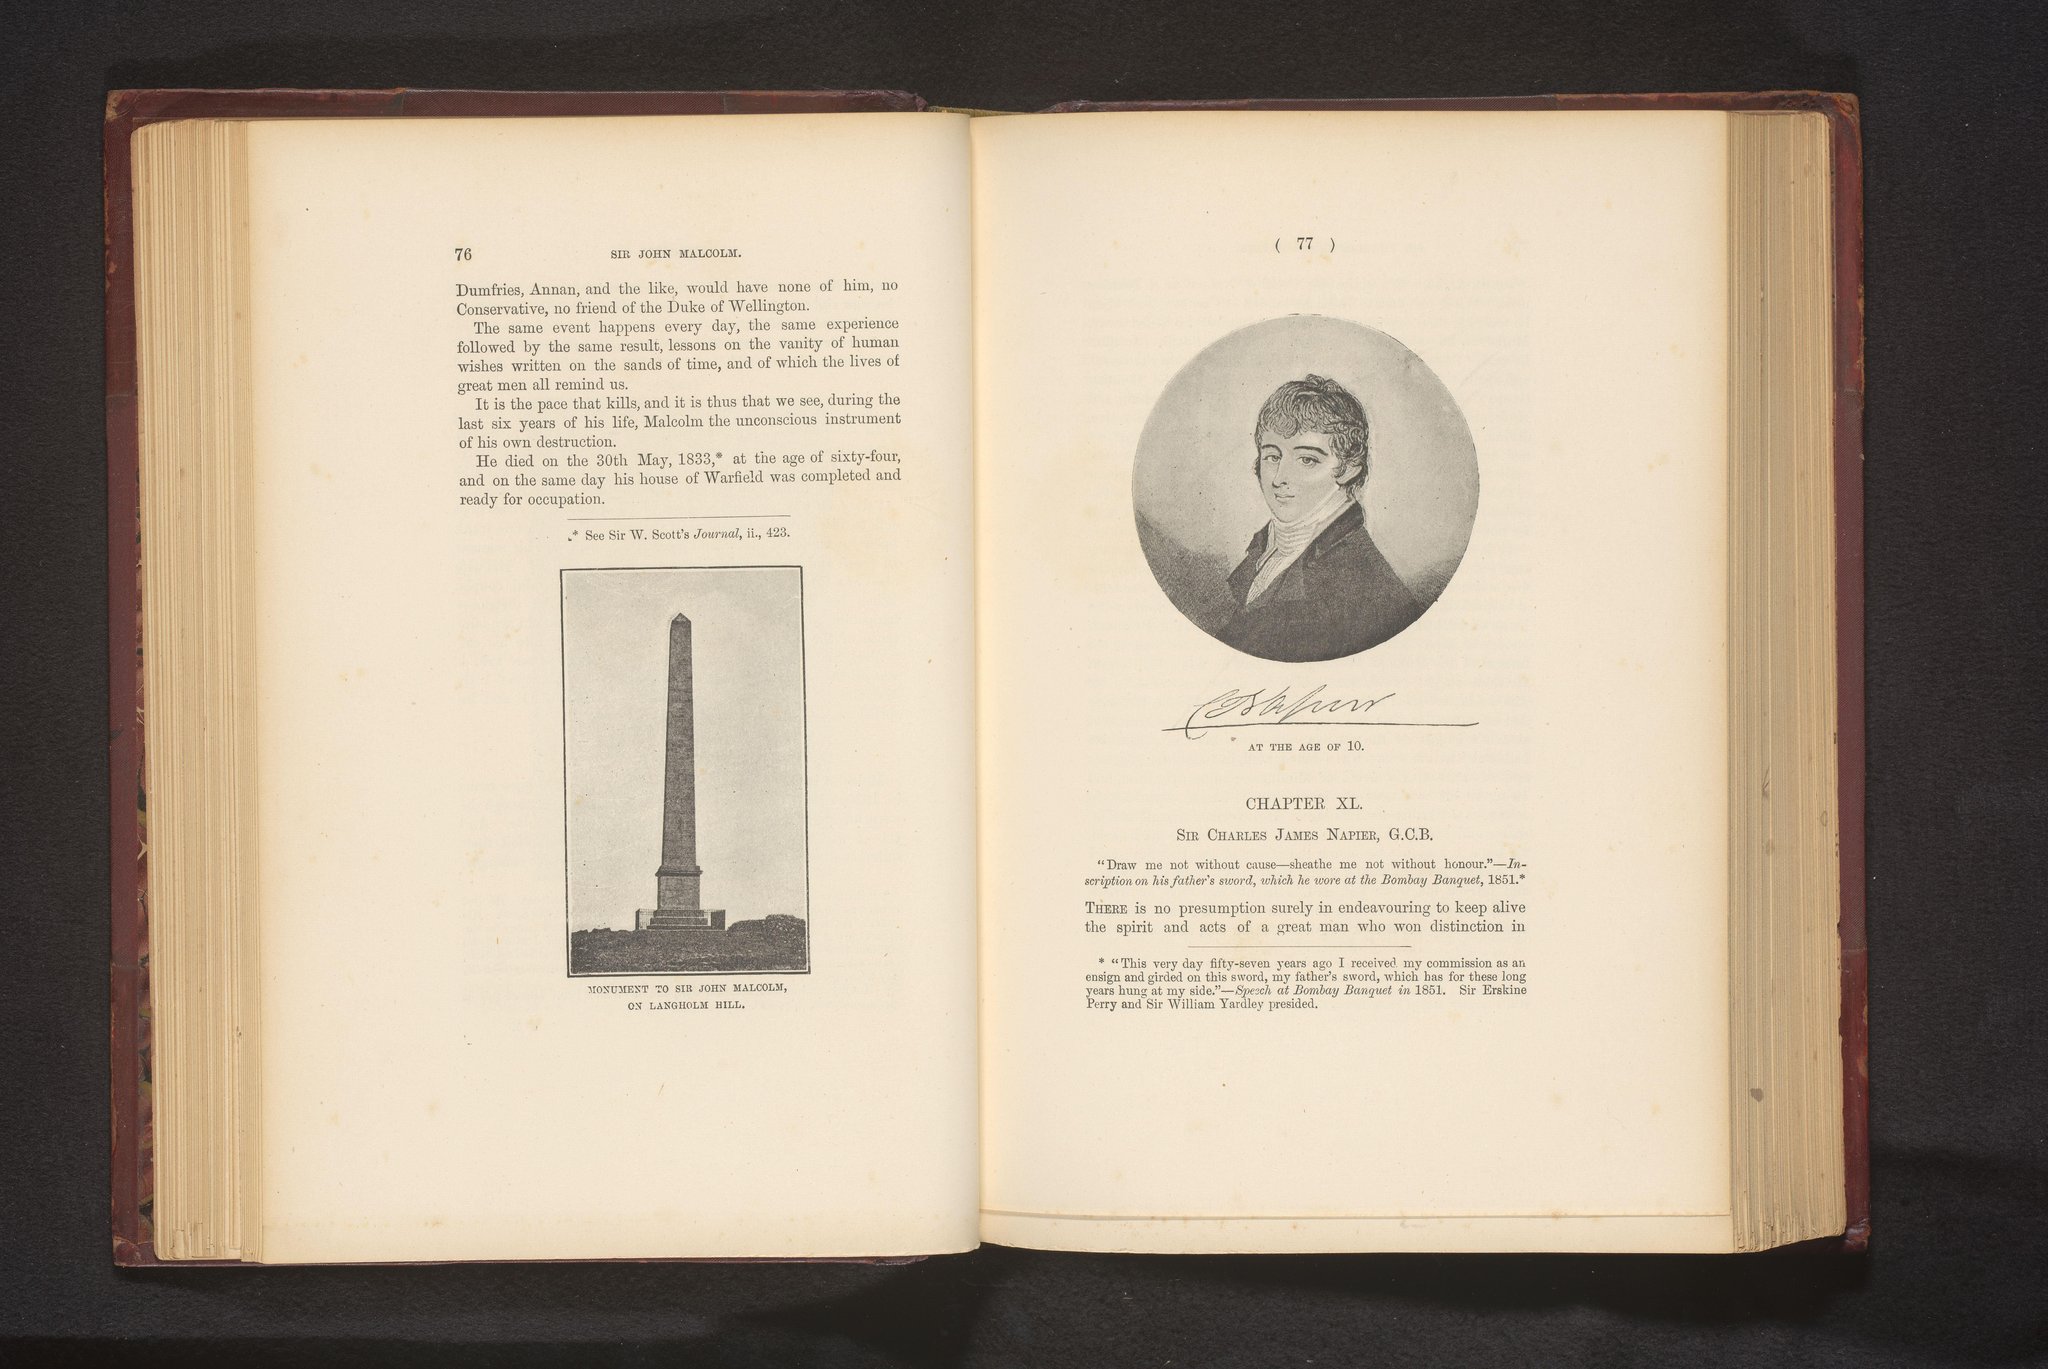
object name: page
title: Monument to Sir John Malcolm on Langholm Hill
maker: Anonymous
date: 1883-1893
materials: paper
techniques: autotype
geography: paris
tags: obelisk, needle